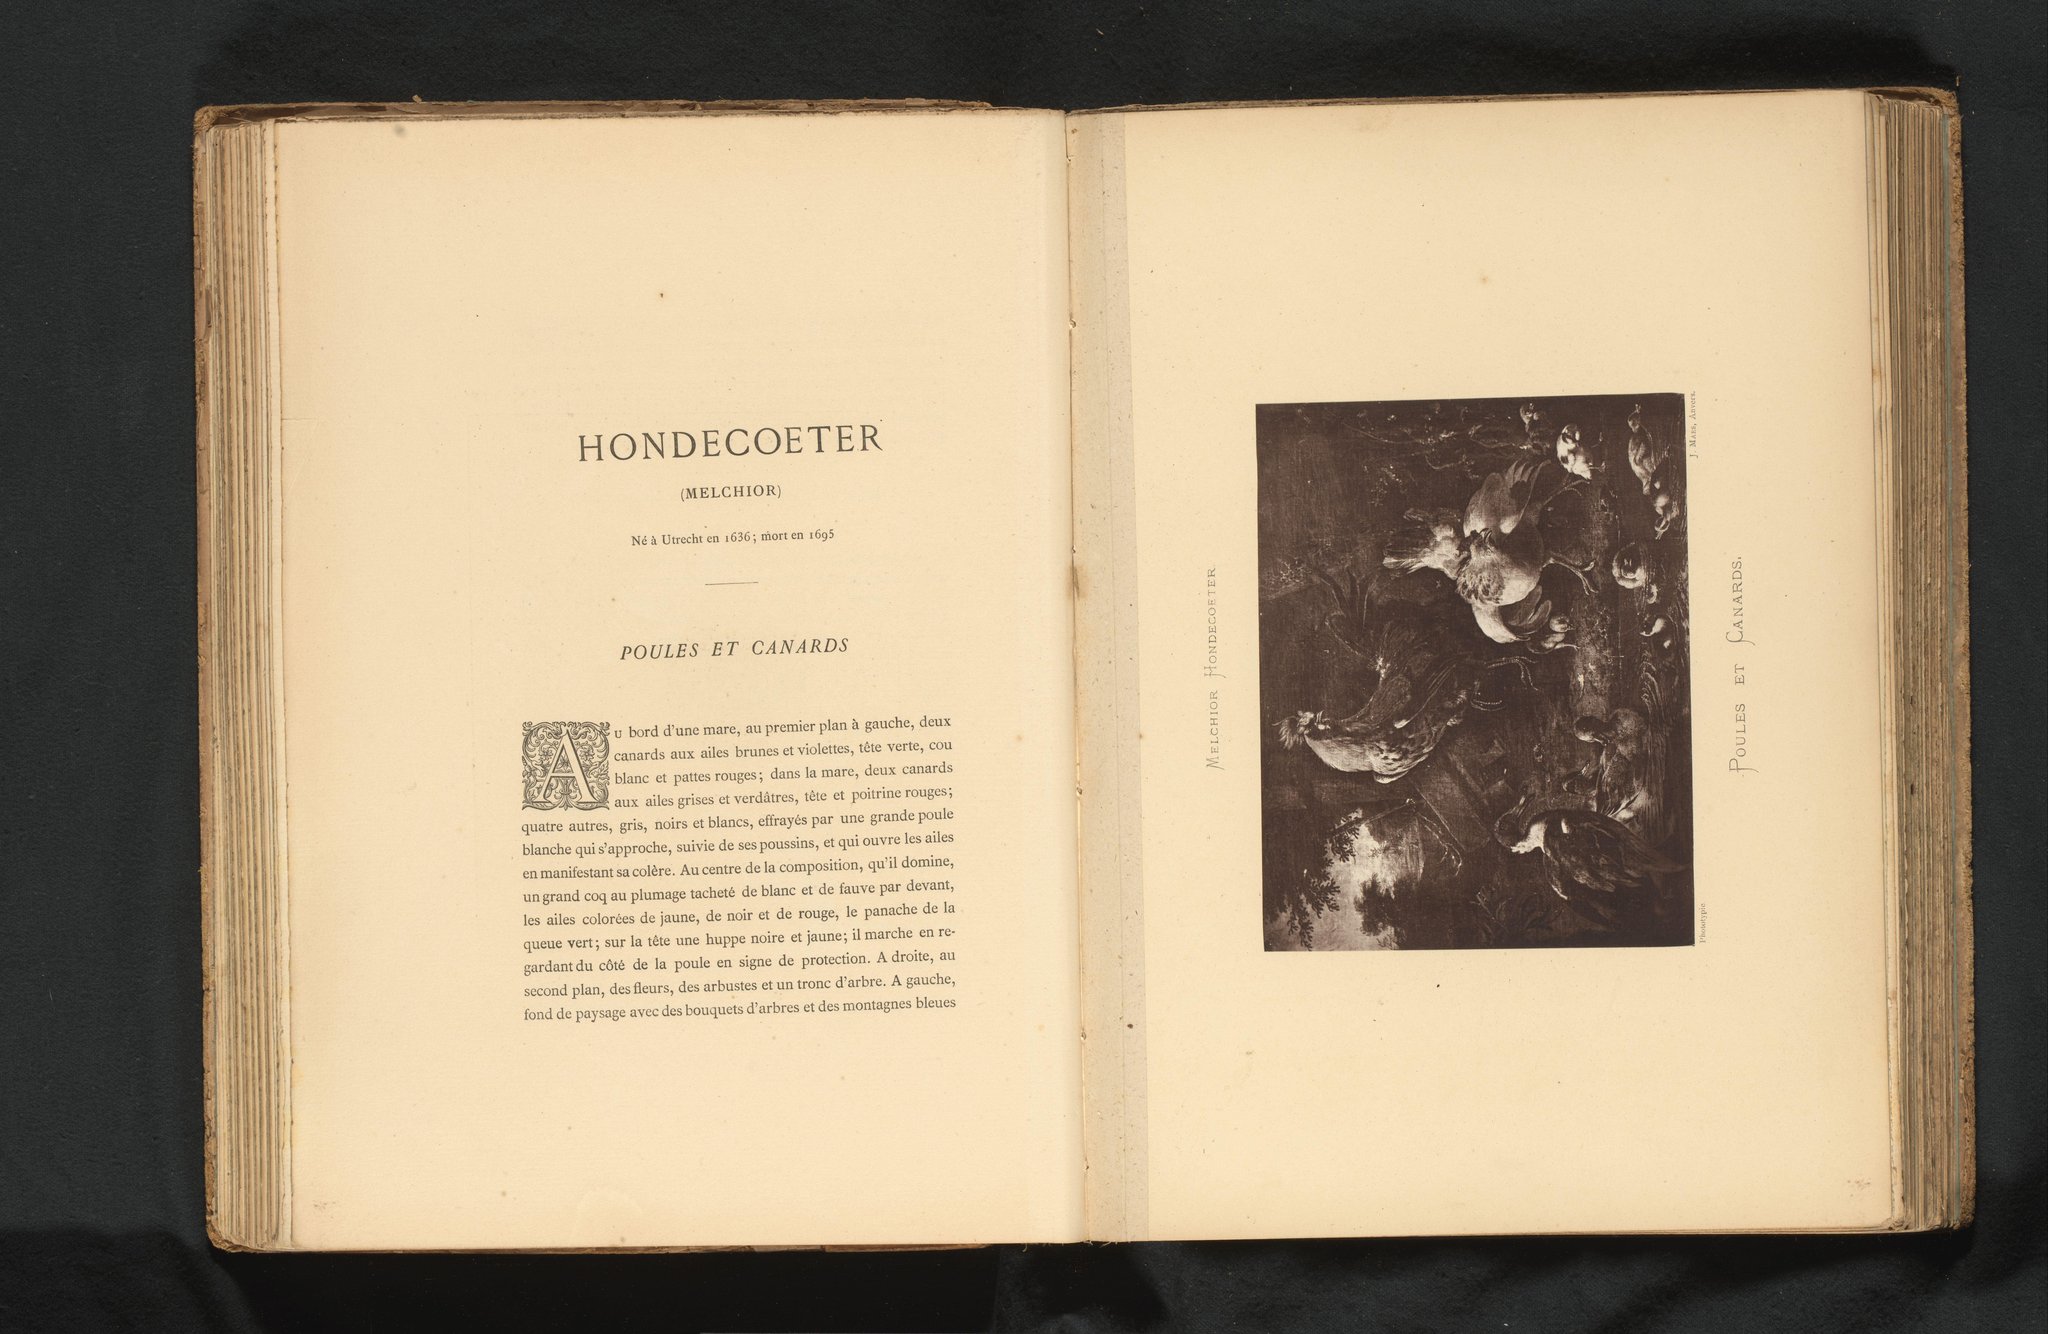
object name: reproduction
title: Reproductie van een schilderij van kippen en eenden door Melchior d'Hondecoeter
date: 1873-1878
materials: paper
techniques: woodburytype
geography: antwerp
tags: fowl (cock, hen, chicken, etc.), ducks (domestic waterbirds)